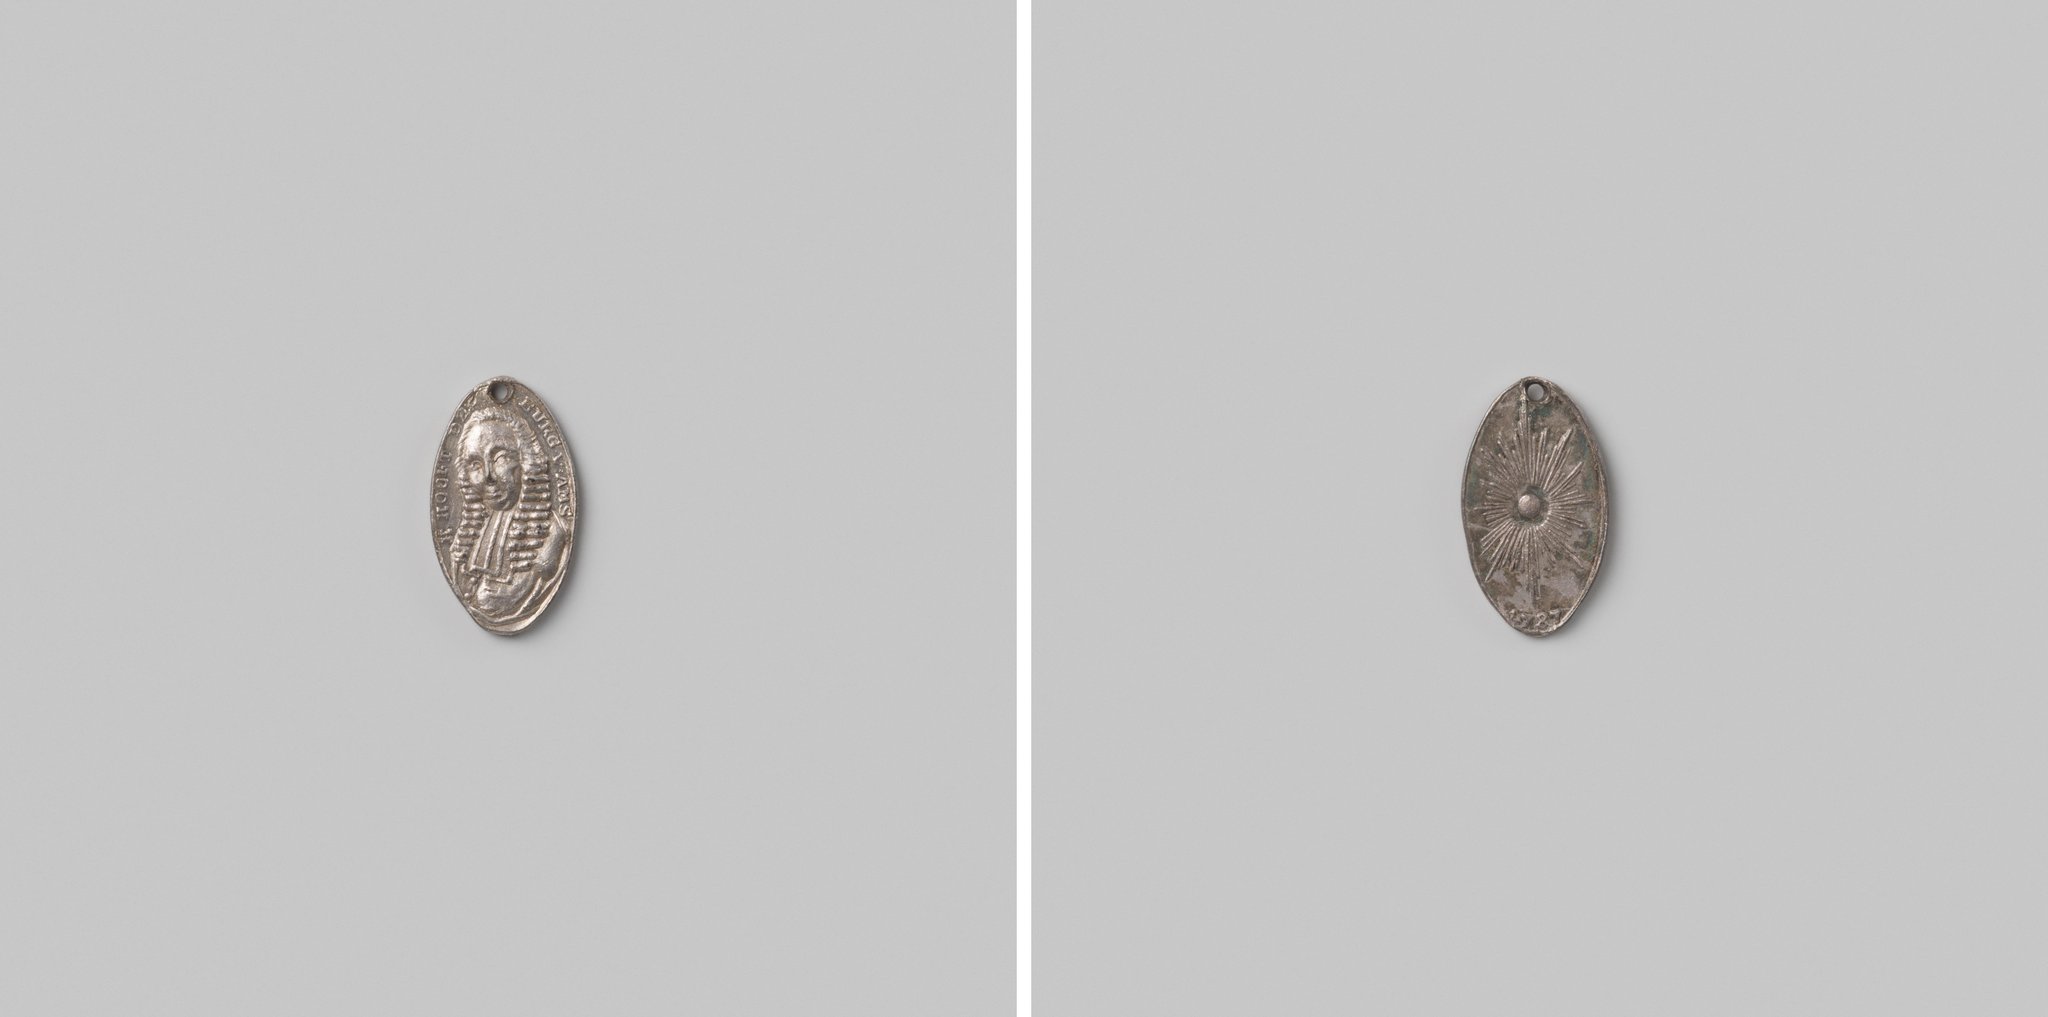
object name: insignia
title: Hendrik Danielsz. Hooft, burgemeester van Amsterdam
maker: Anonymous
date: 1787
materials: silver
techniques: striking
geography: netherlands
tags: amsterdam, mayor, hendrik danielsz. hooft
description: Zilveren ovale draagteken met gat erin. Voorzijde: borststuk man binnen omschrift. Keerzijde: stralende zon boven jaartal